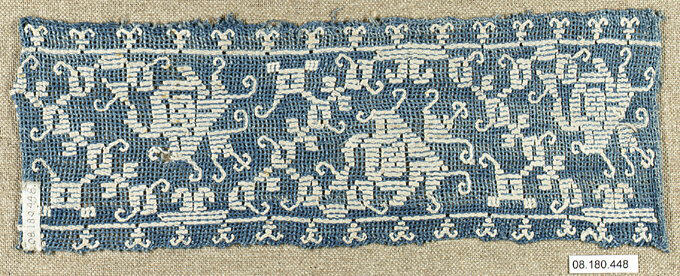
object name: border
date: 1501-1600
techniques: embroidery